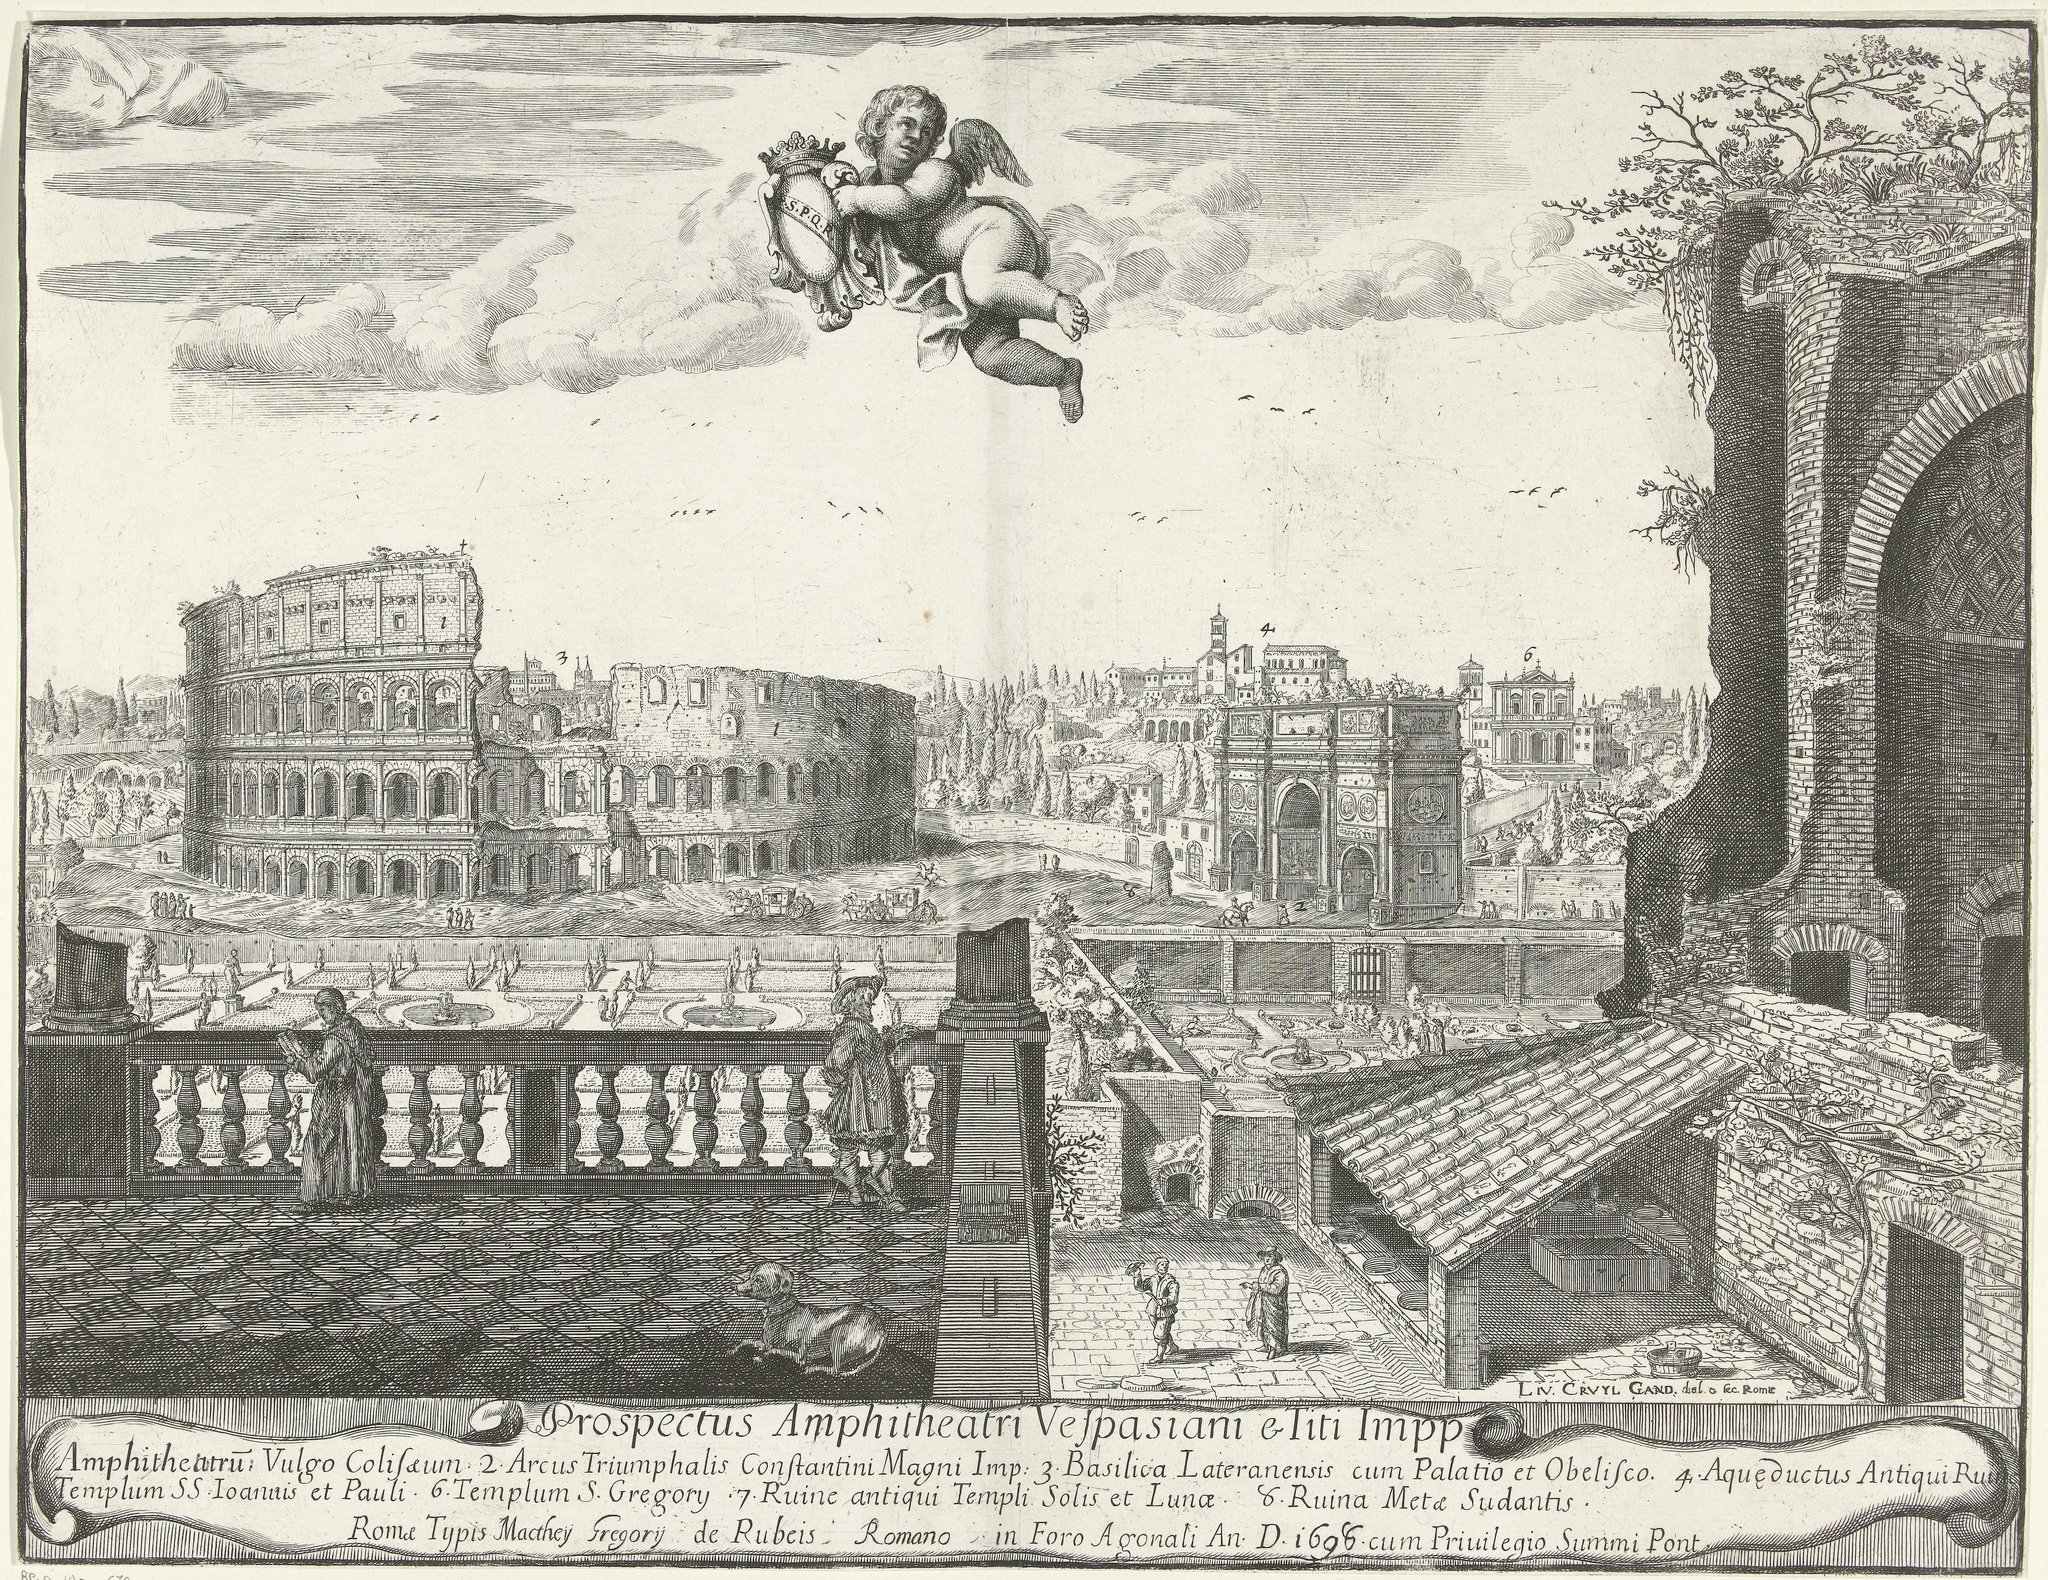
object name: print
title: Gezicht op het Colosseum en de boog van Constantijn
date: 1696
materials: paper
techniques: etching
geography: rome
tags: rome, arch of constantine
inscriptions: collector's mark: Lugt 2228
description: Gezicht op het Colosseum. Rechts de Boog van Constantijn. In het midden van de prent zweeft een engeltje met het wapenschild van Rome. Er staan nummers op de prent die verwijzen naar specifieke gebouwen in Rome. De prent heeft een Latijns onderschrift met een verklaring van de nummers.